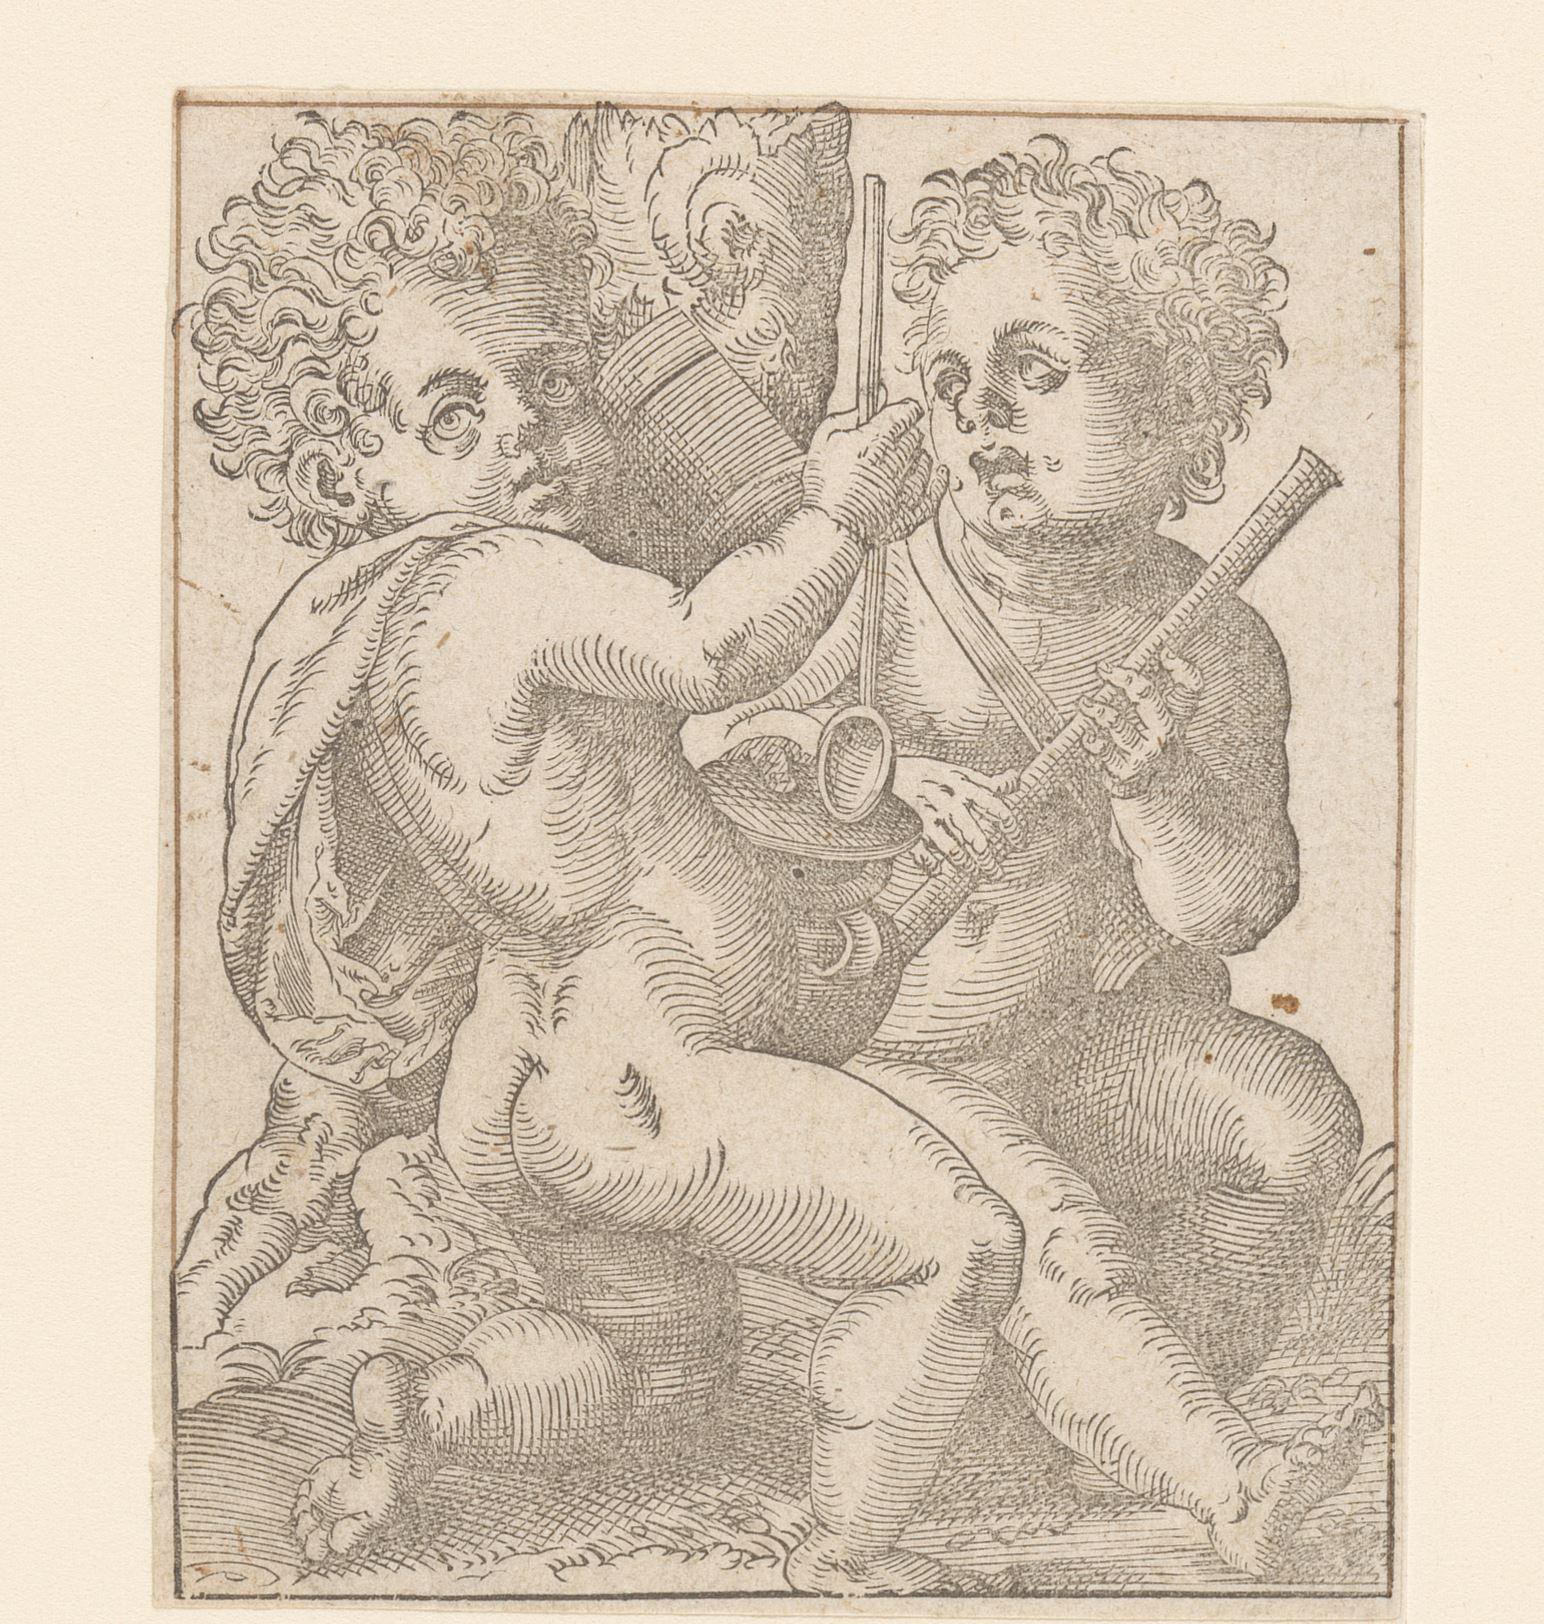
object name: print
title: Twee putti spelen muziek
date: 1580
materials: paper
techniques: woodcut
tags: cupids together with attributes of the arts, sciences, etc.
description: Prent ook gebruikt in: Amman, Jost. Kunstbüchlein. Frankfurt am Main: Feyerabend, 1580.